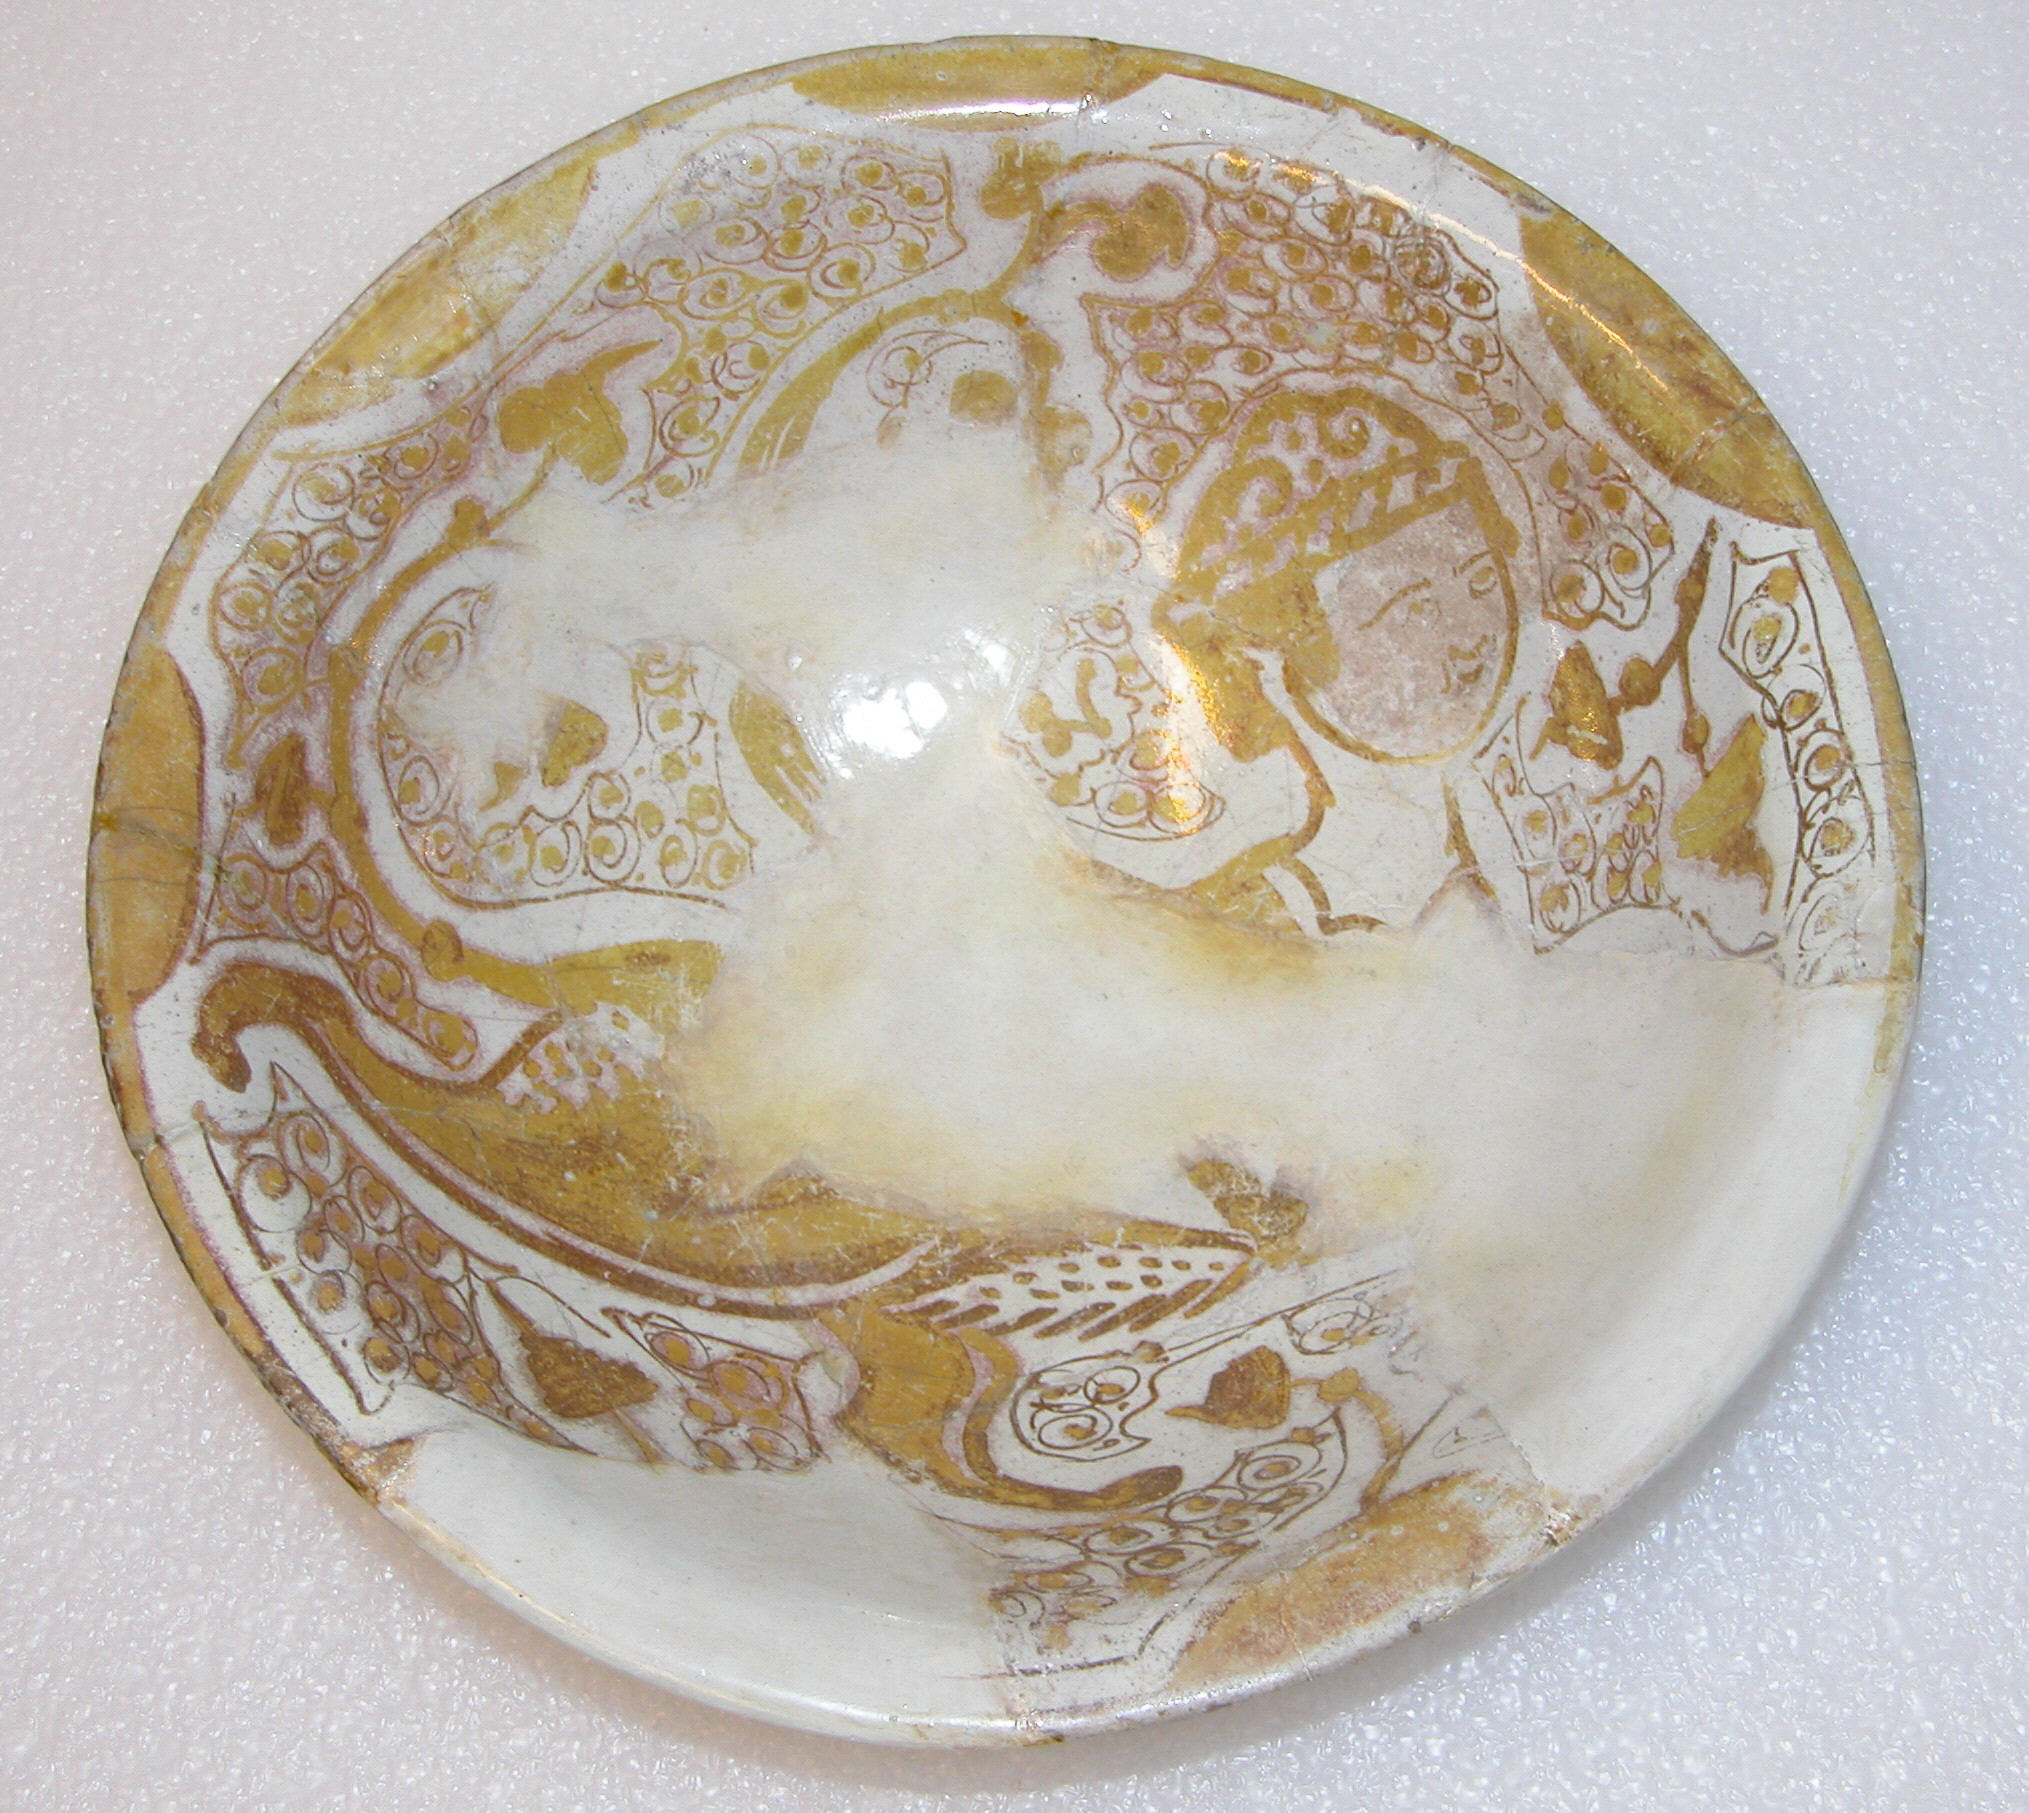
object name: bowl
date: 951-1000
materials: earthenware, glaze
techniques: luster painting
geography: egypt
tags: faces